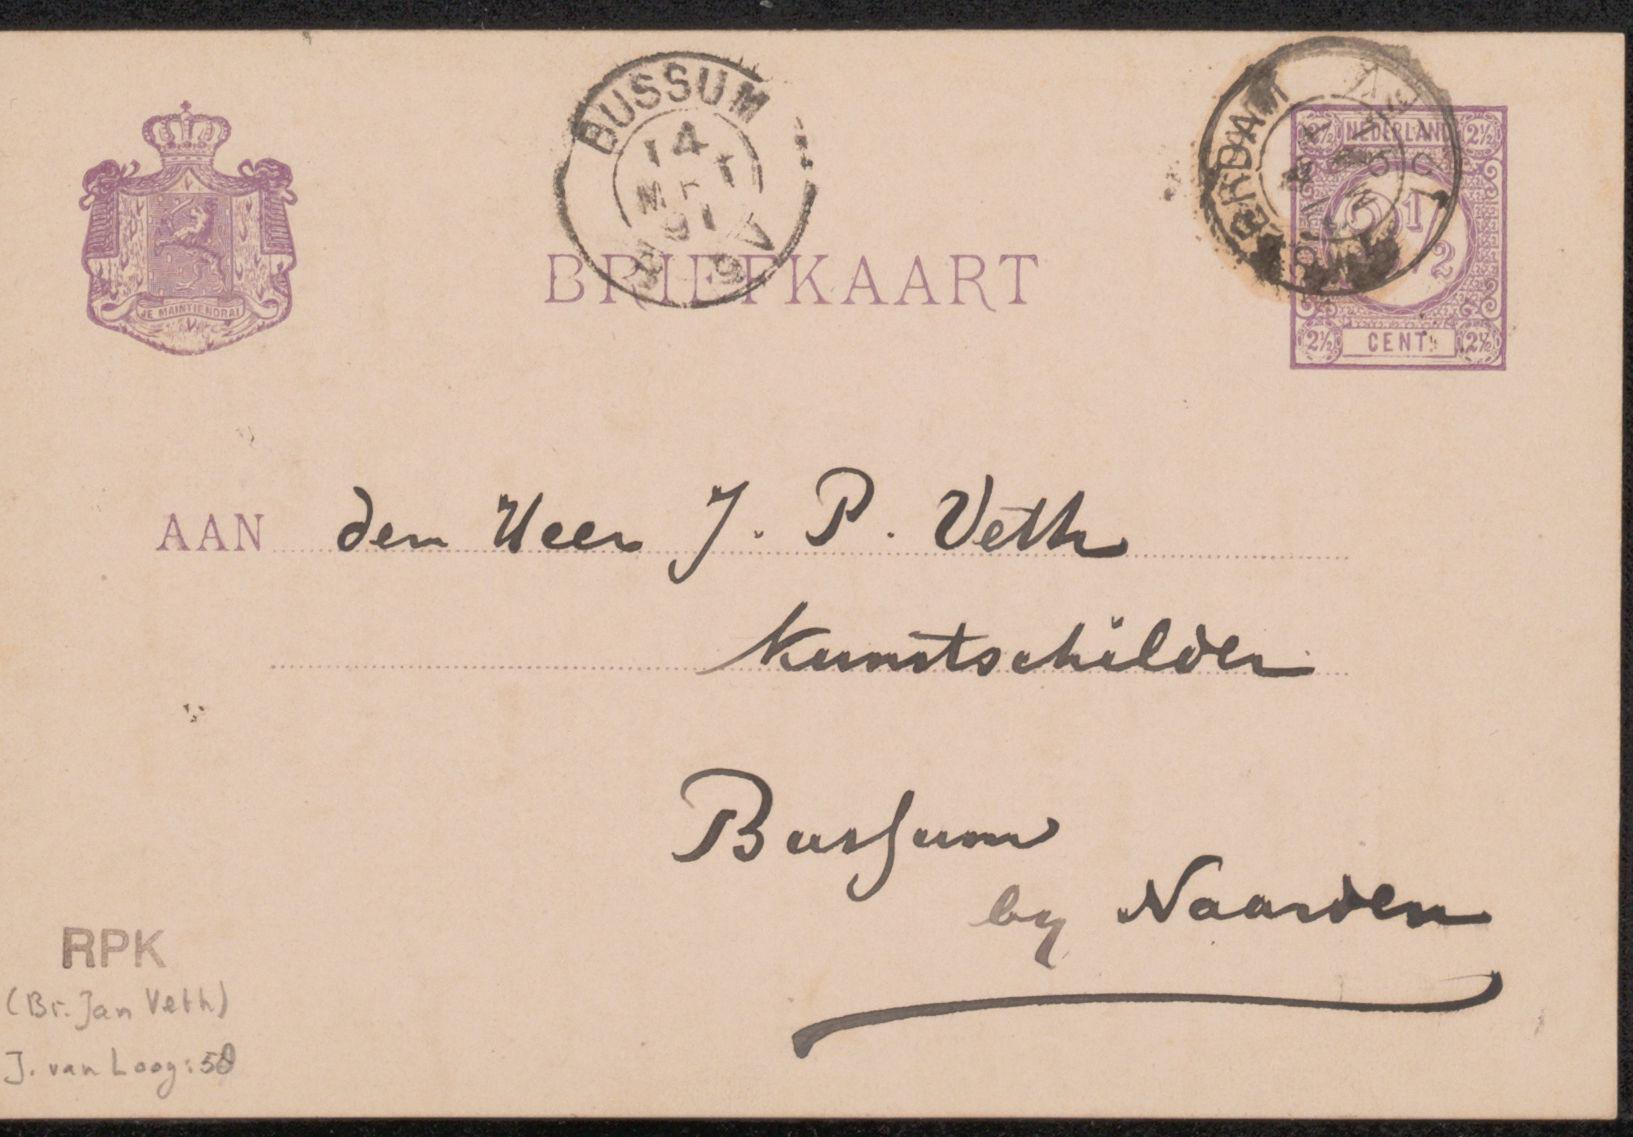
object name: postcard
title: Briefkaart aan Jan Veth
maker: jac van looij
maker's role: draughtsman, painter, print maker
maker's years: 1855-1930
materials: cardboard, ink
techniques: pen, writing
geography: amsterdam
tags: designer, jan veth, painter, print maker, draughtsman, jean françois millet, haarlem, utrecht, nicolaas beets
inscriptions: collector's mark: ‘RPK’